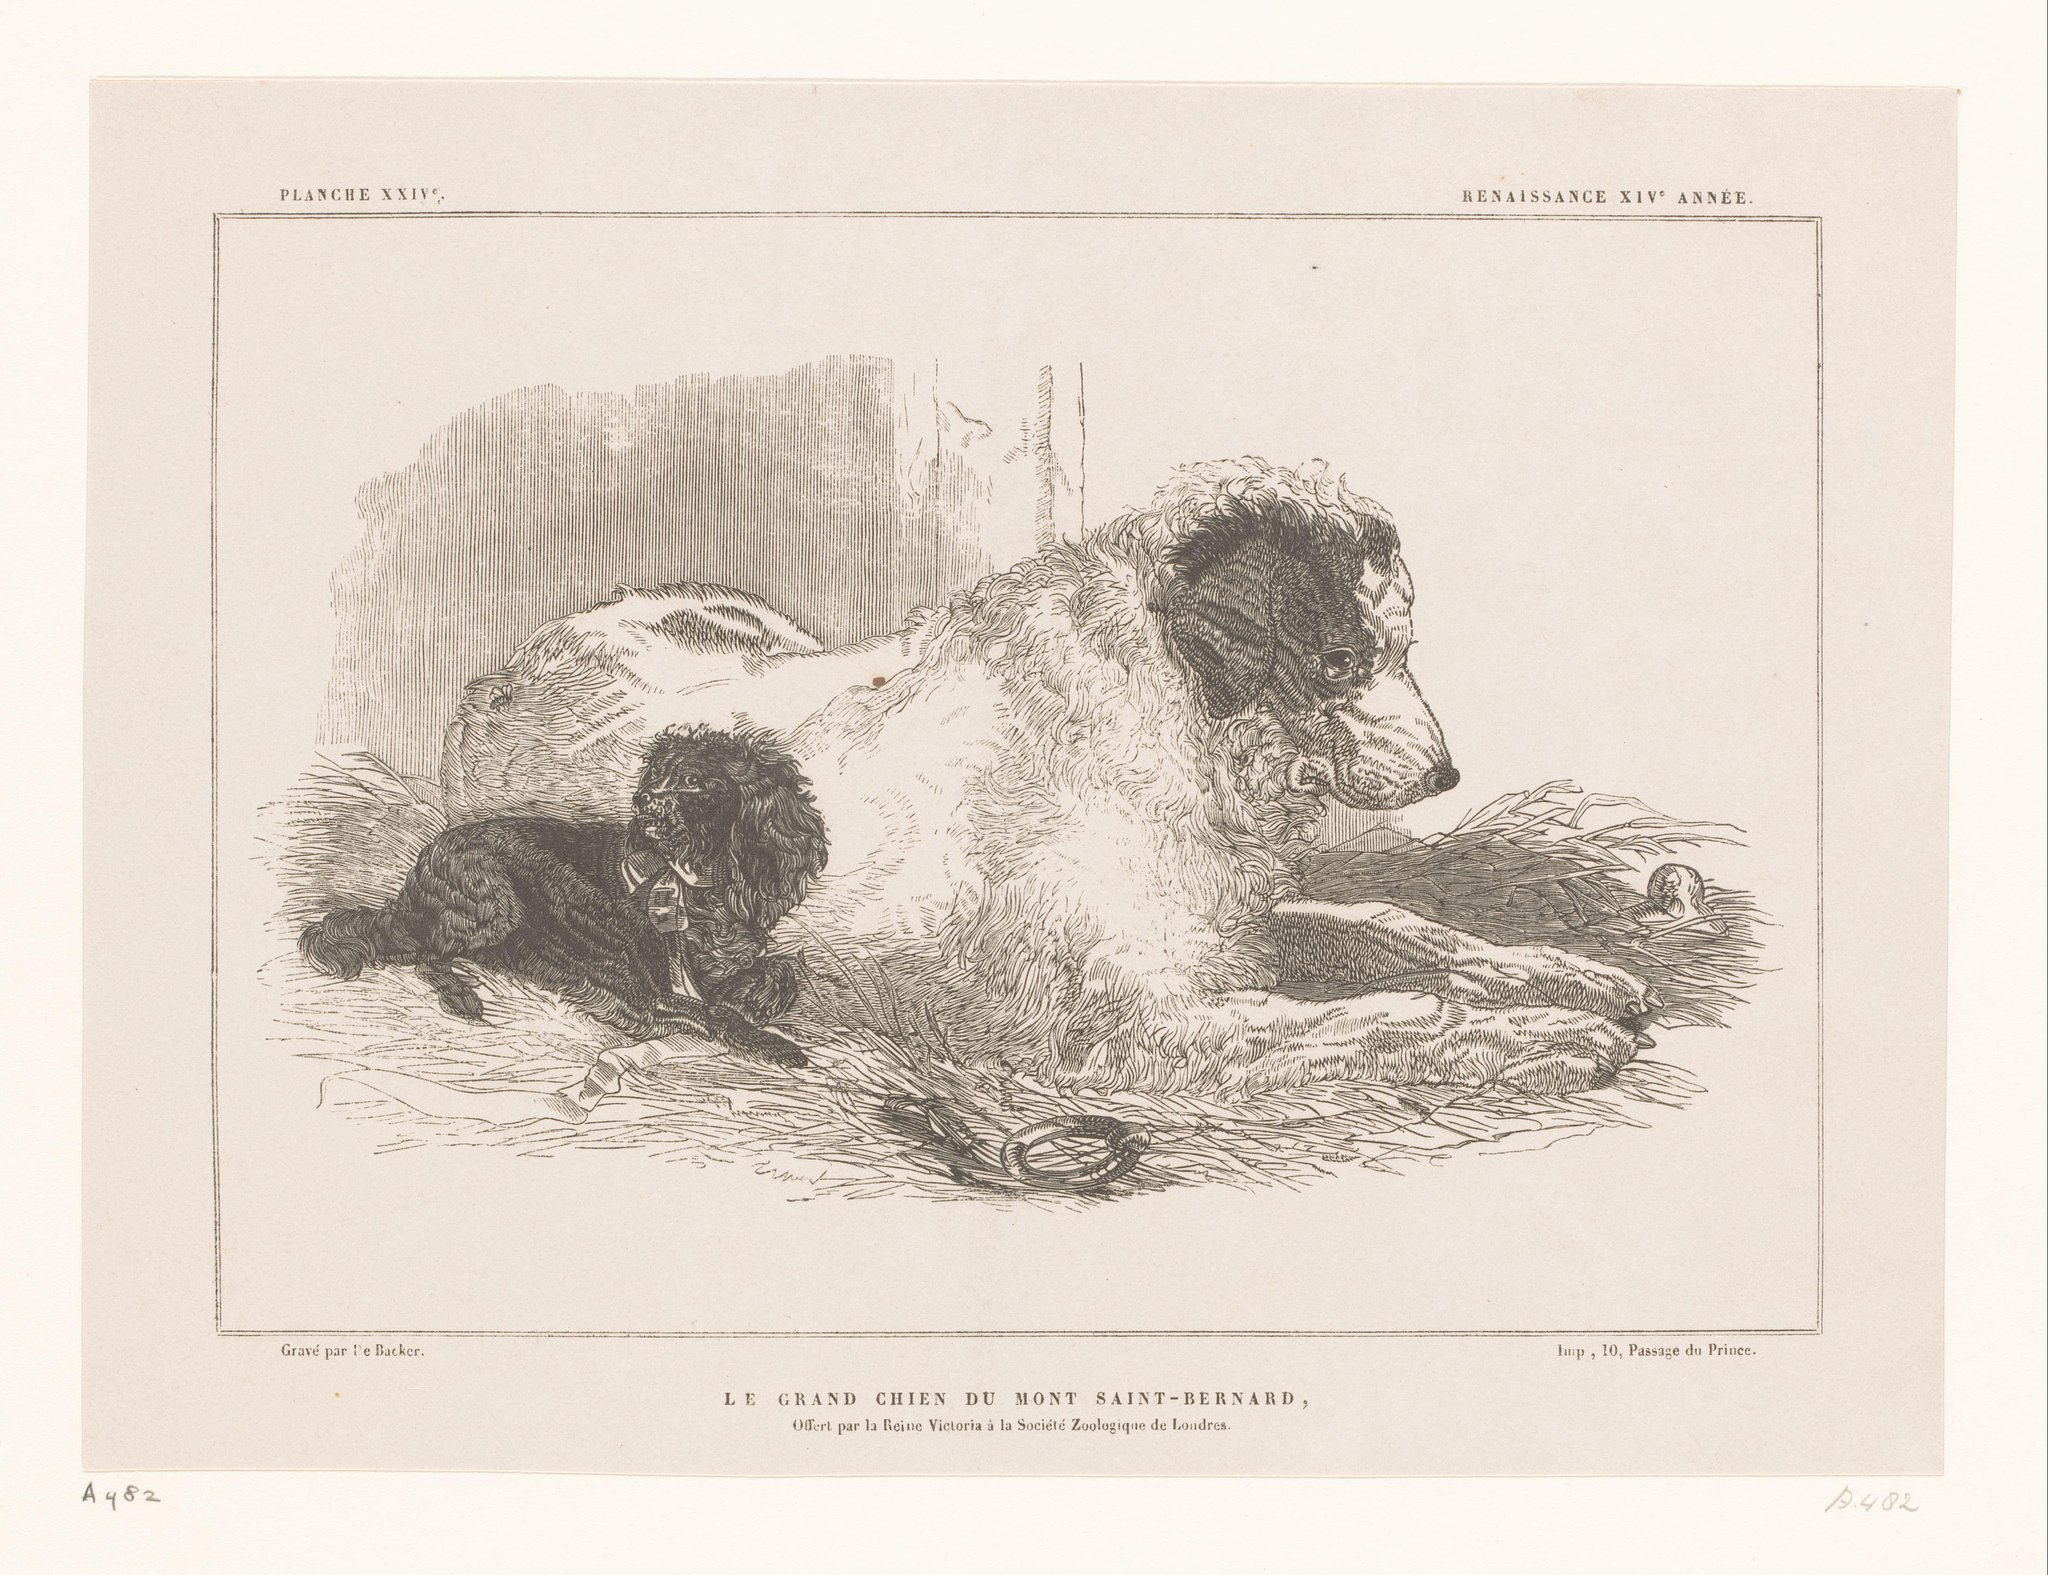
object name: print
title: Twee honden in het hooi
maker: de backer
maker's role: print maker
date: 1800-1878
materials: paper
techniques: engraving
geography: brussels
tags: dog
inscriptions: collector's mark: Lugt 2228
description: Prent verschenen in: La Renaissance. Chronique des arts et de la littérature 14 (1852), pl. 24.